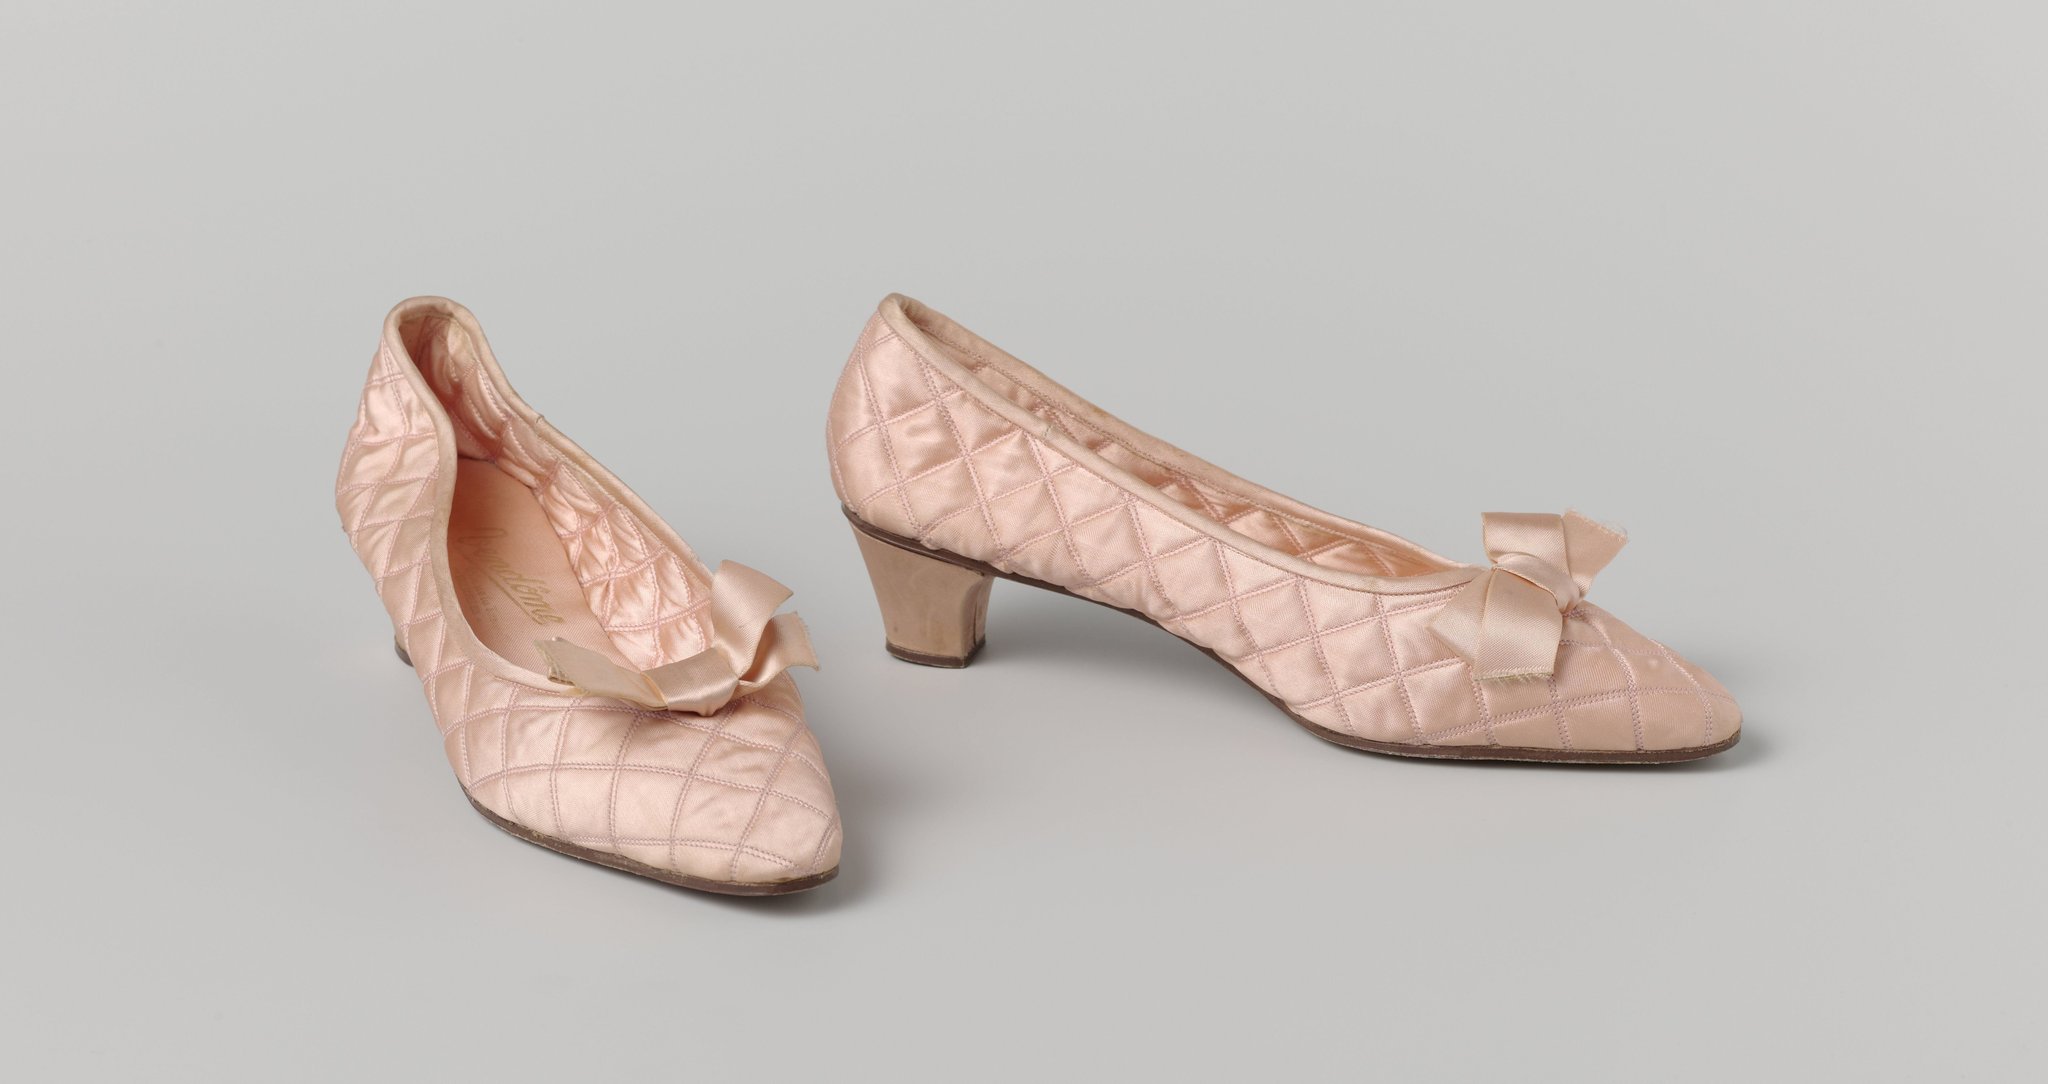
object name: huisschoen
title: Pump of huisschoen van doorgestikte satijn met platte strik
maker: vendôme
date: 1930-1970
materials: leather, textile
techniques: quilting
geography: brussels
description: Rechterpump of huisschoen van doorgestikte satijn met platte strik. Model: laag uitgesneden instap. Achternaad. Lage (4 cm) rechte hak bekleed met satijn. Ongevoerd. Satijnen binnenzool met gouden opdruk. Adres: VENDOME/15a AV. DE LA TOUR/BRUXELLES.